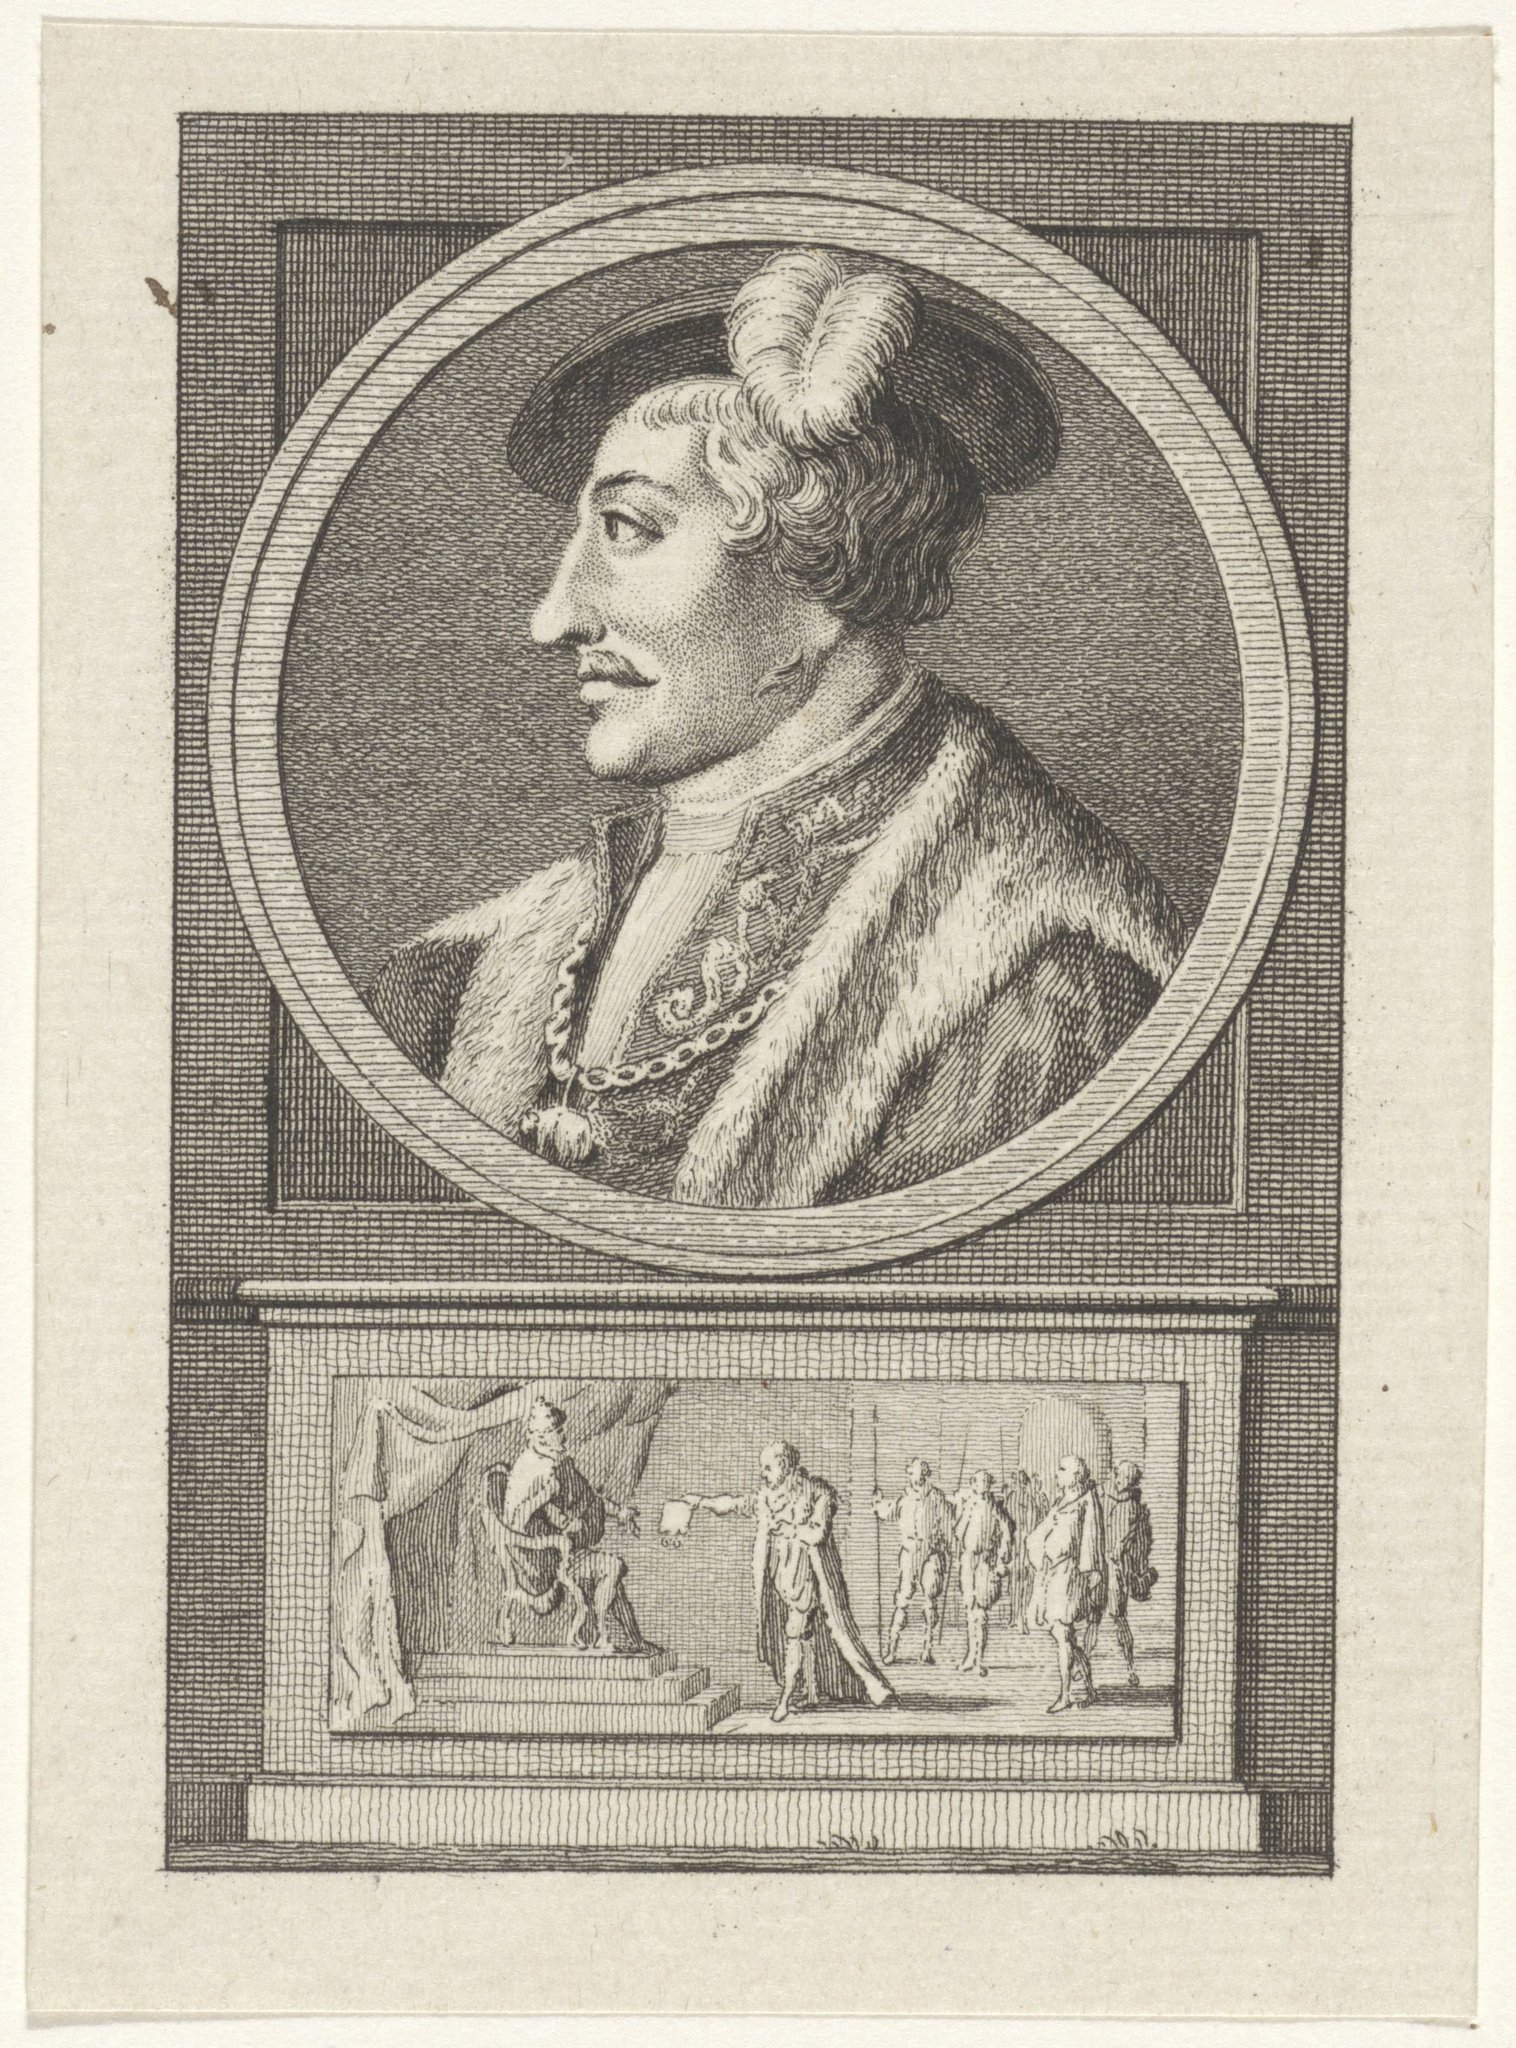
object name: print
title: Portret van een onbekende man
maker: reinier vinkeles (i)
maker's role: draughtsman, print maker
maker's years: 1741-1816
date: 1783-1795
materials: paper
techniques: engraving, etching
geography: amsterdam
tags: throne, knighthood order of the golden fleece, (diplomat) presenting credentials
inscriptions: collector's mark: Lugt 2228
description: Latere staat prent vermoedelijk gebruikt in: Fokke, Jan. Geschiedenissen der Vereenigde Nederlanden voor de vaderlandsche jeugd Ie-XXVste deel. Amsterdam: Johannes Allart, 1783-1795.